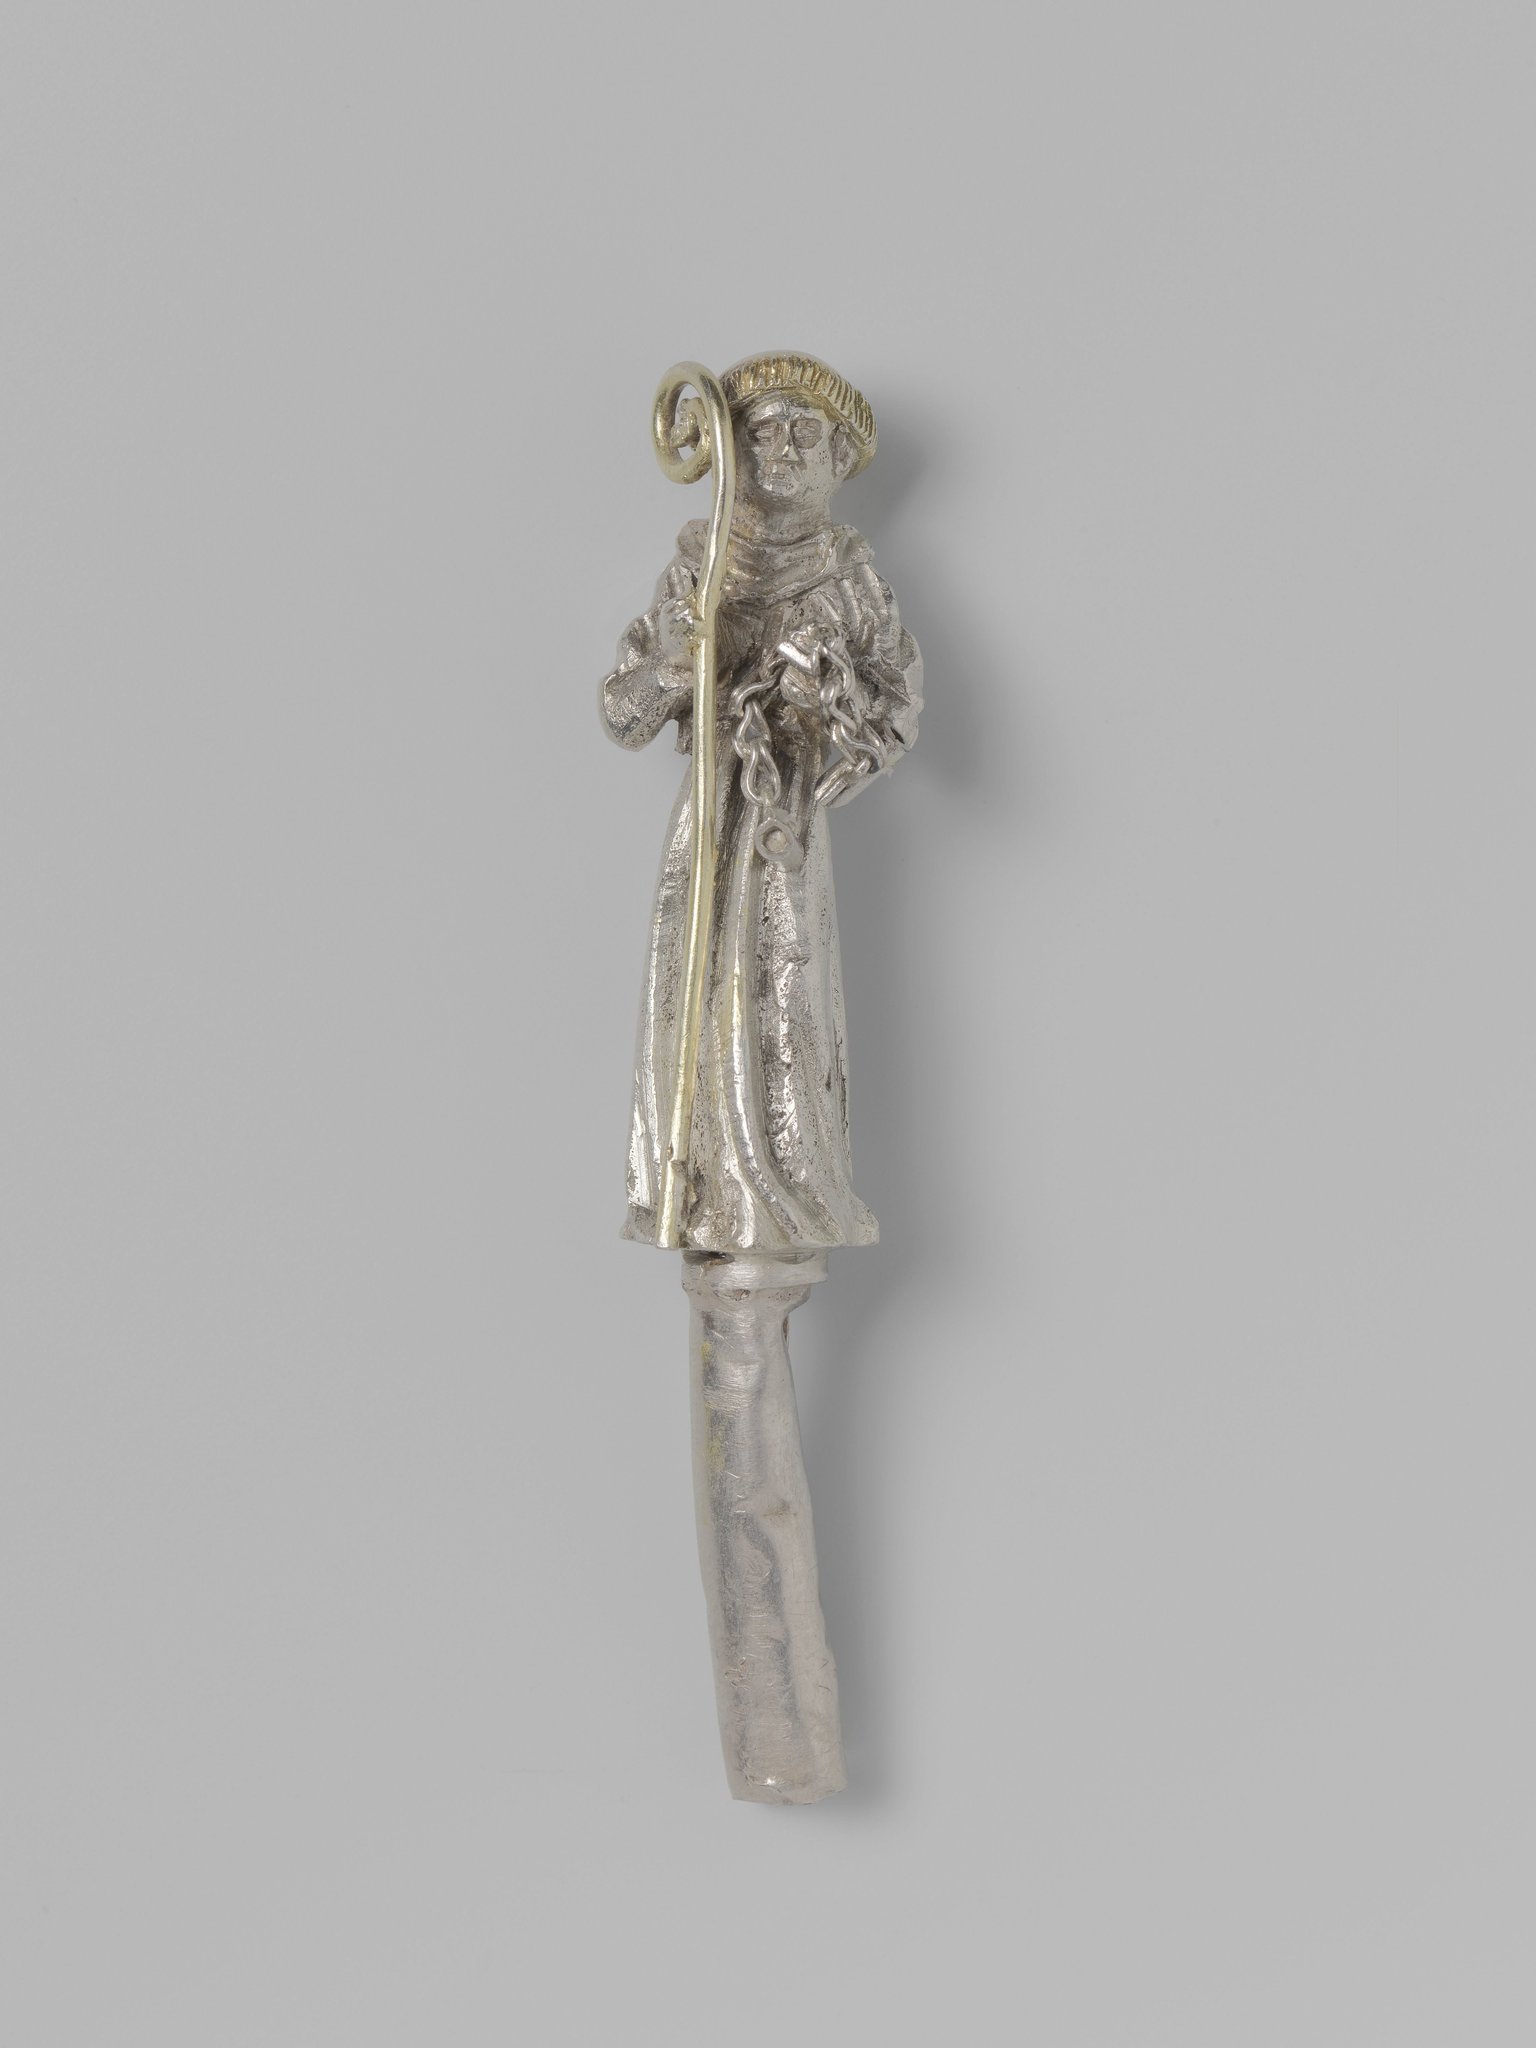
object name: part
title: Beeld van gegoten zilver, voorstellende de Heilige Leonardus met staf, gebroken boei en ketting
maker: Anonymous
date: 1480-1500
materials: silver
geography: northern netherlands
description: Five figurines. Silver. Netherlands, c. 1480 - 1500.